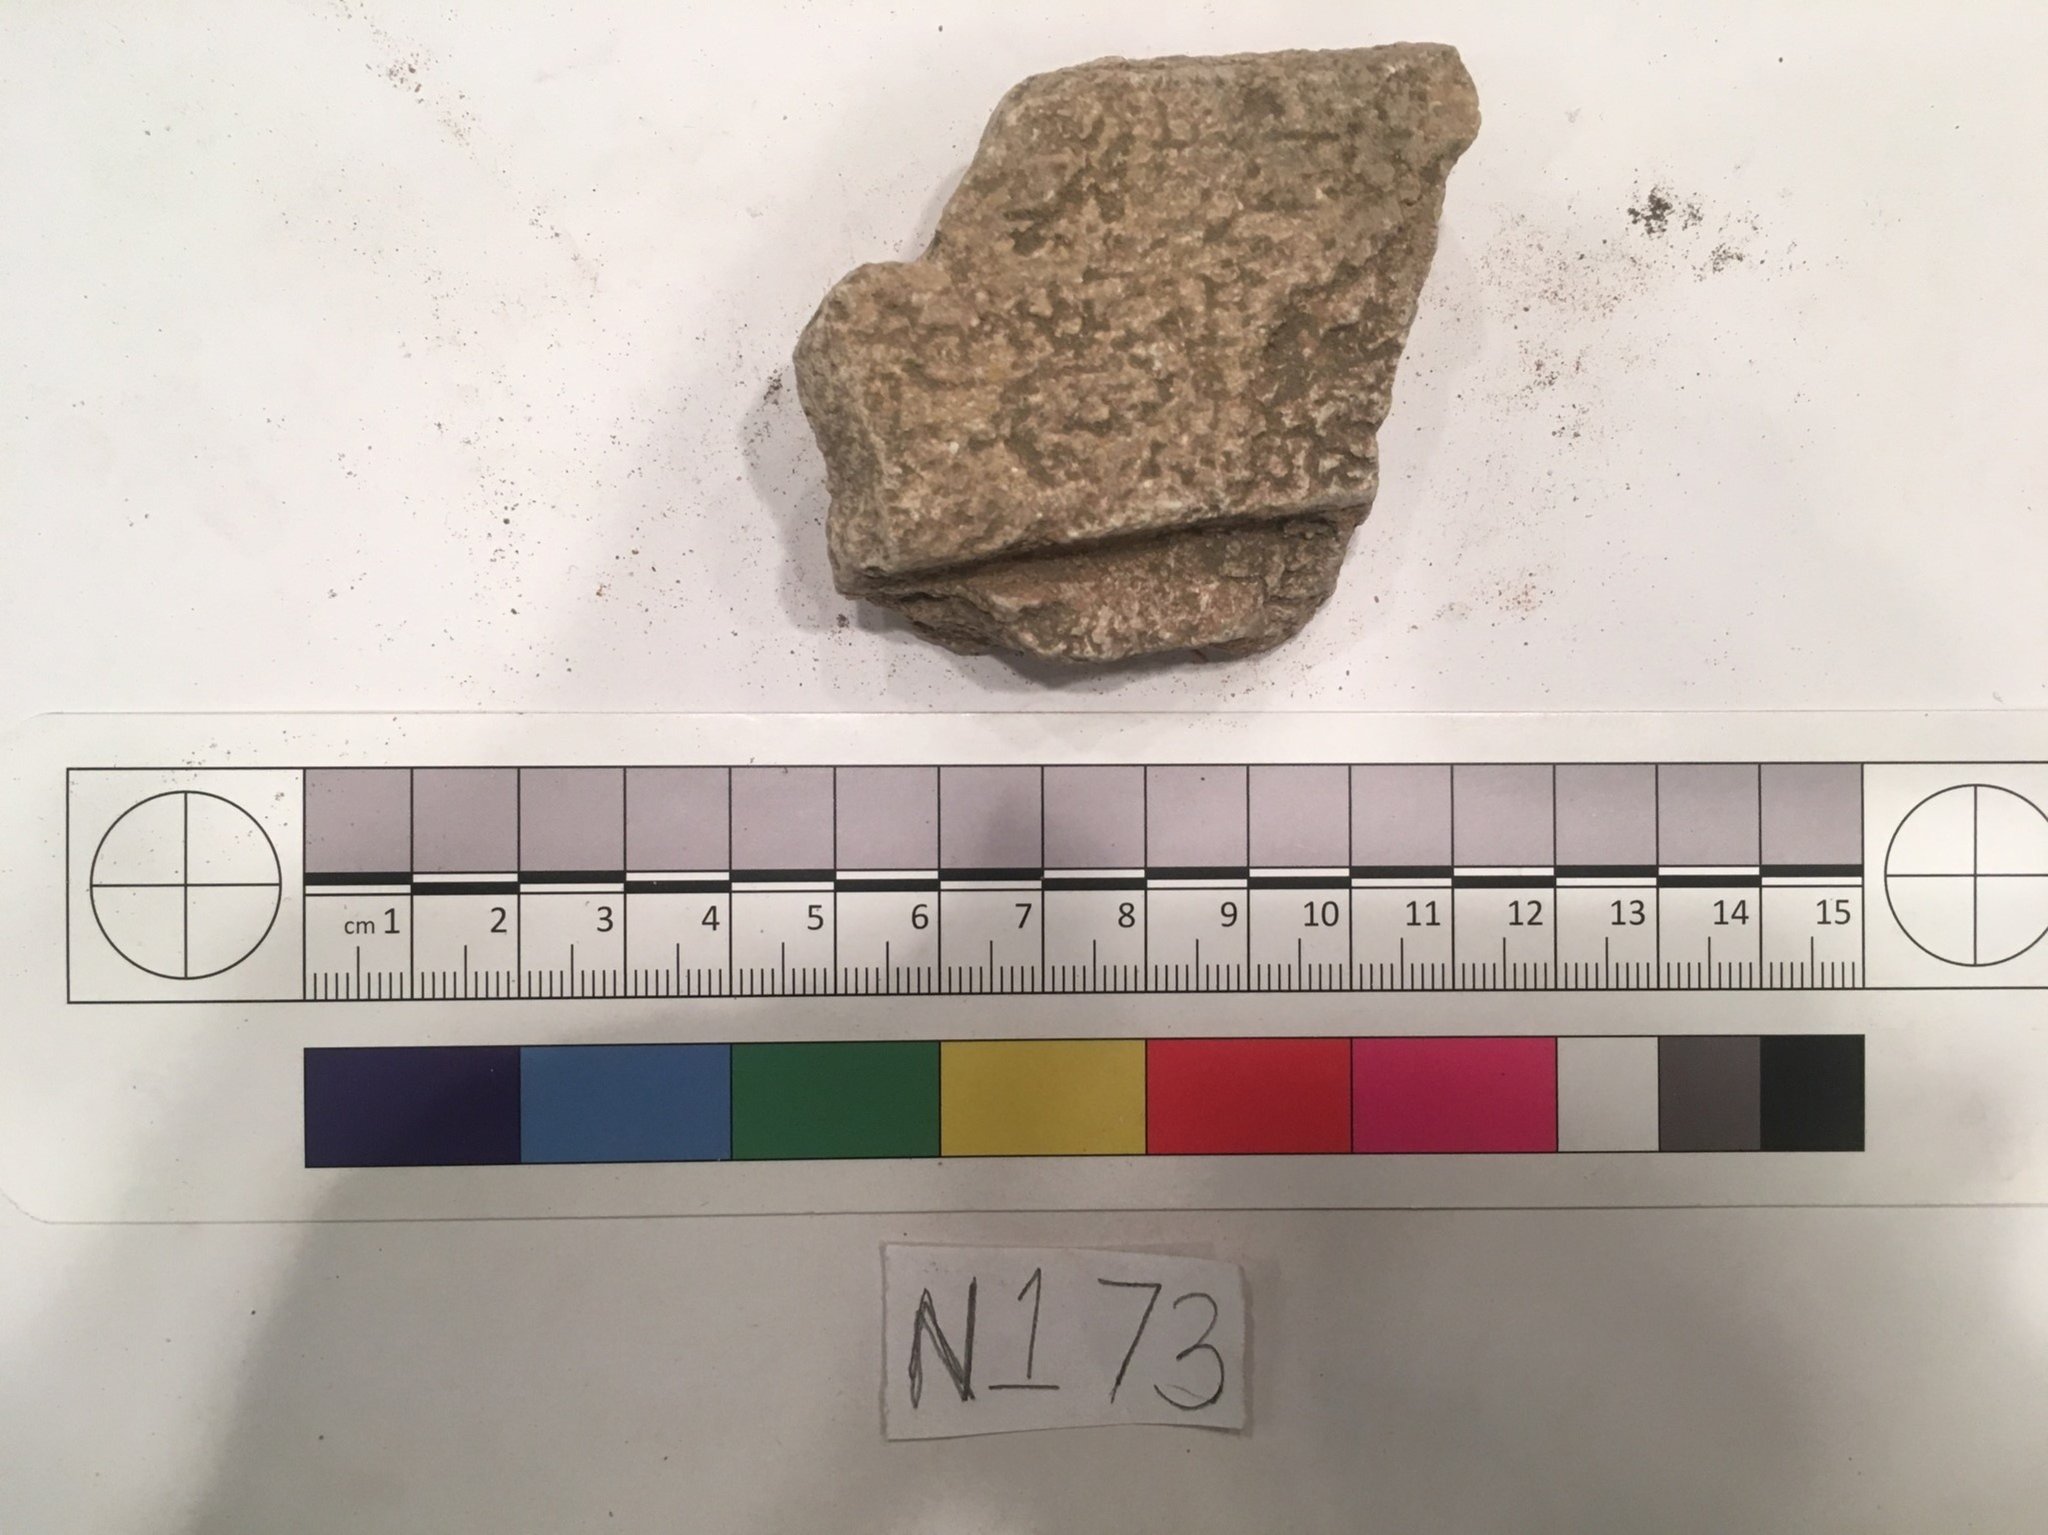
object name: fragment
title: Stucco Fragment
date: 701-1200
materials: plaster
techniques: carving, painting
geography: iran